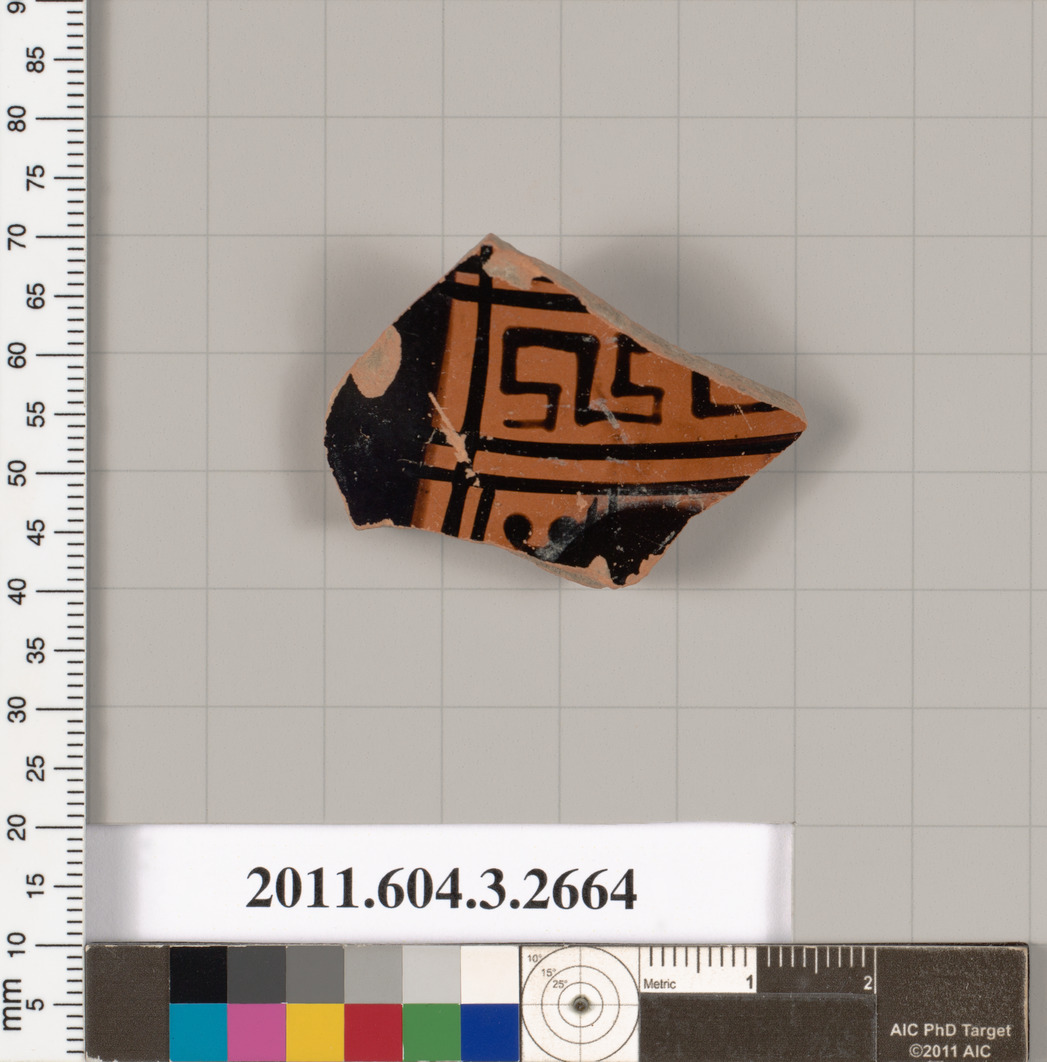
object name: olpe fragment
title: Terracotta fragment of an olpe (jug)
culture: greek, attic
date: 530-500 BCE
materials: terracotta